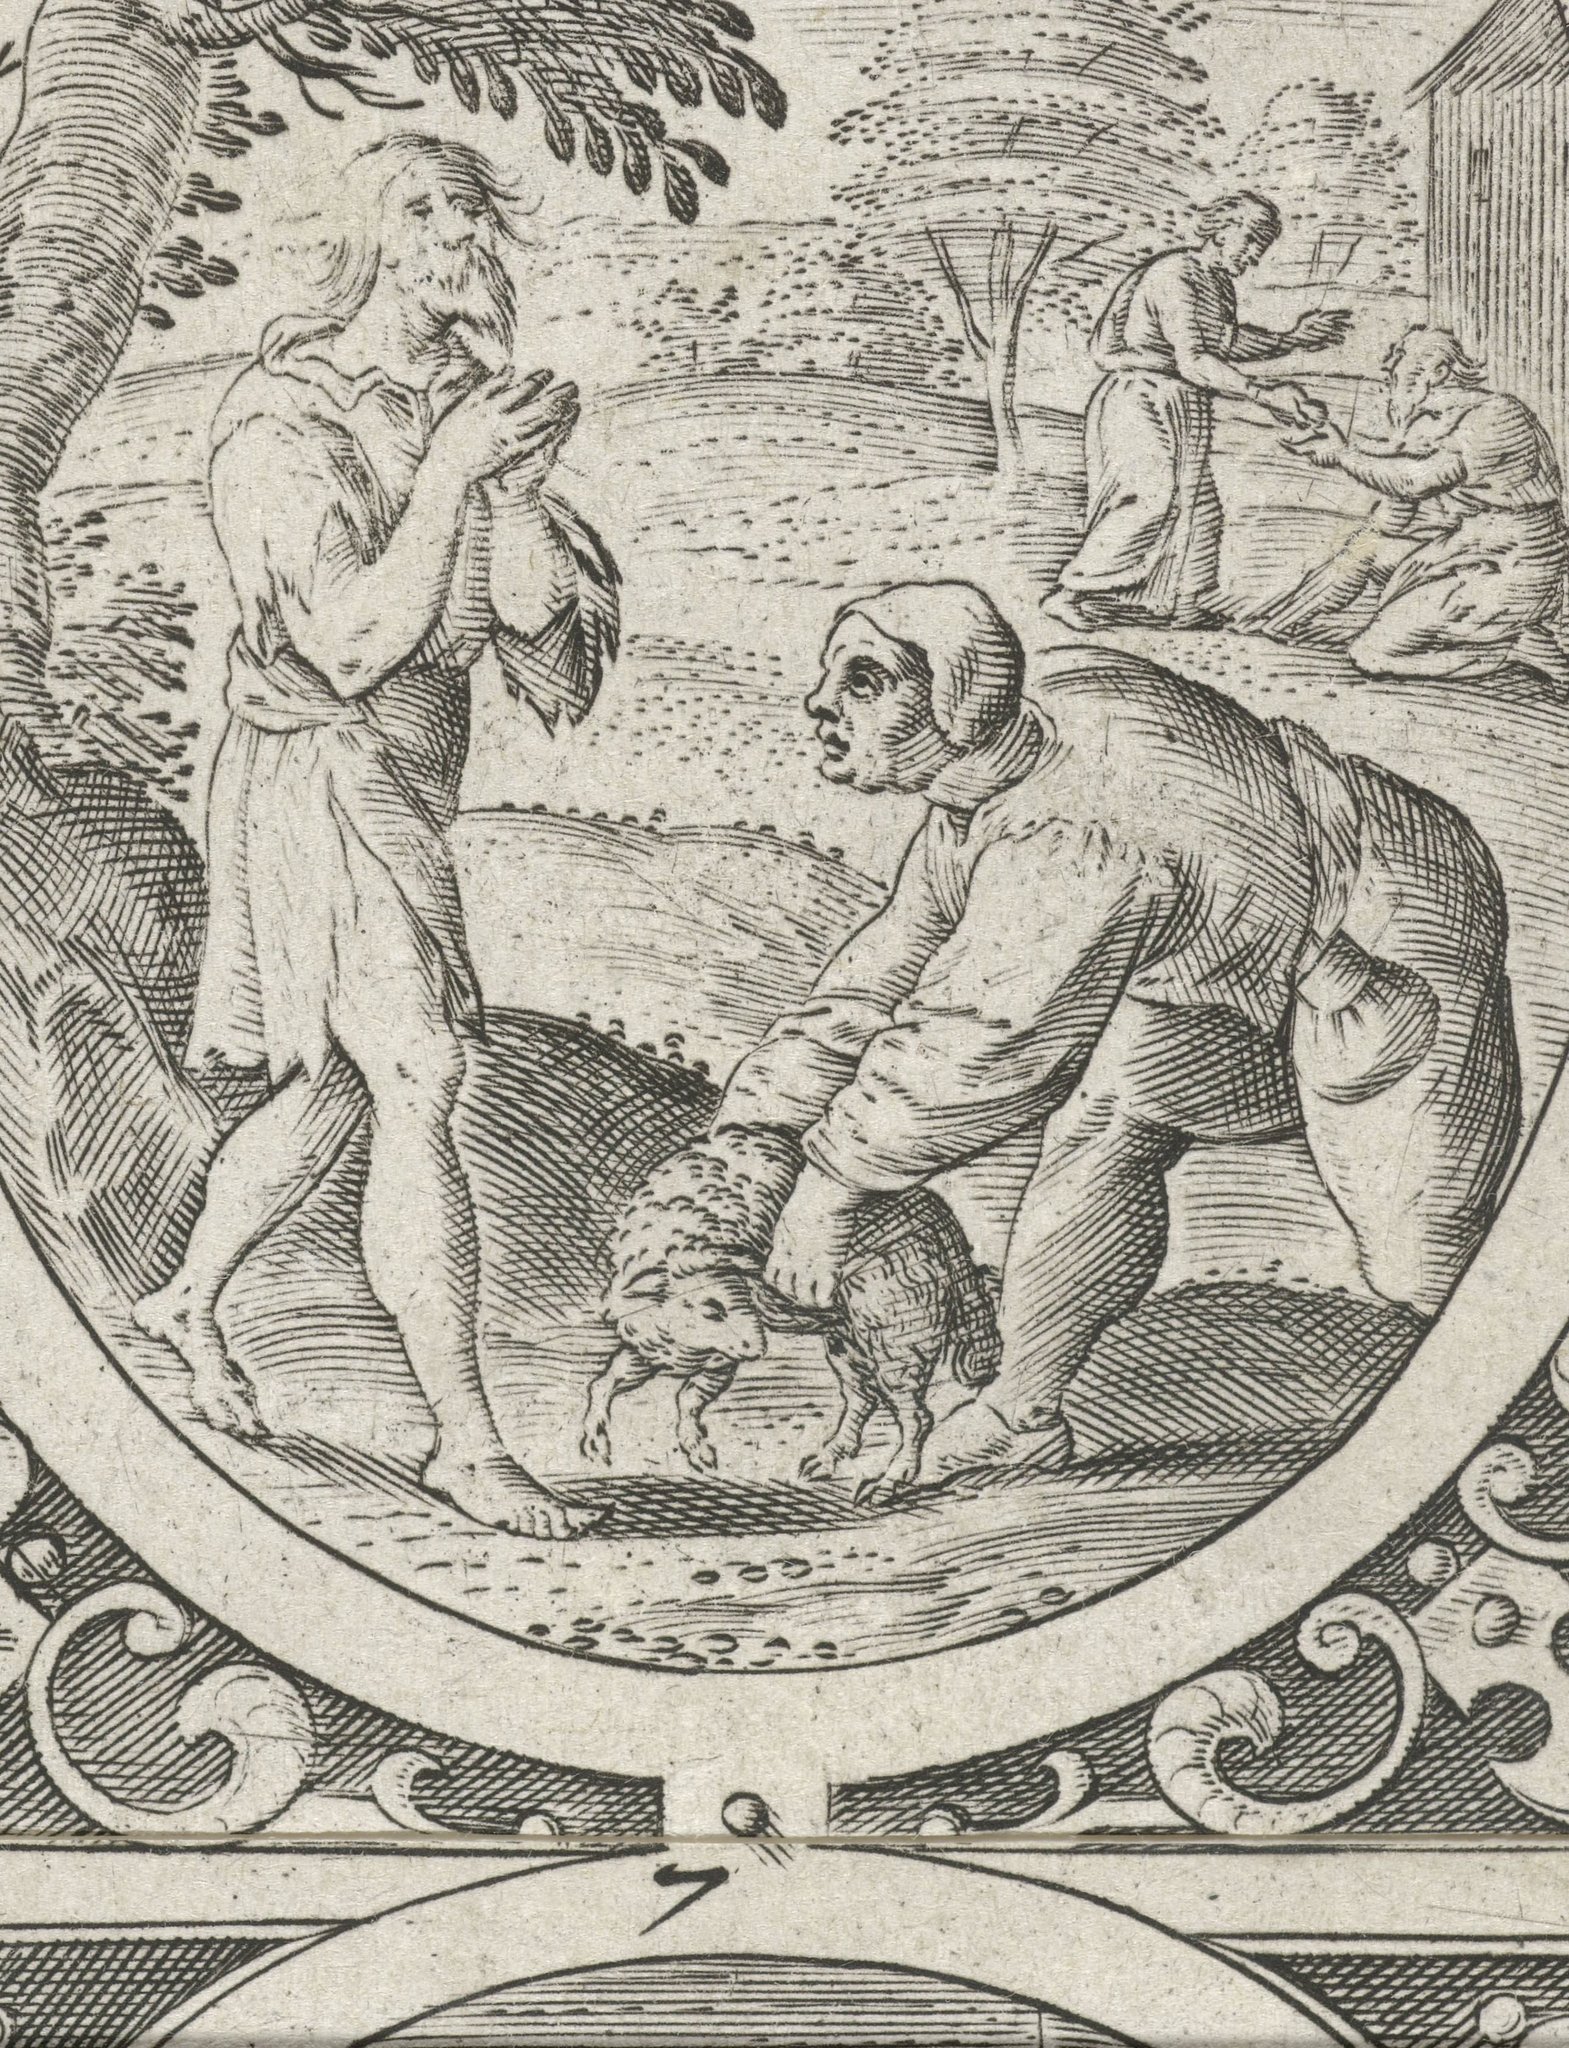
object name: print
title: Spreuken van Salomo, linkerdeel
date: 1547-1591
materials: paper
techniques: engraving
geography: antwerp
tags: the book of proverbs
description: Ornamentele omlijsting met medaillon waarin een man in gebed en een gehurkte man met een lam. Op de achtergrond ontvangt een gehurkte oude man iets van een andere man. Boven hen in een stralenkrans een tetragram.